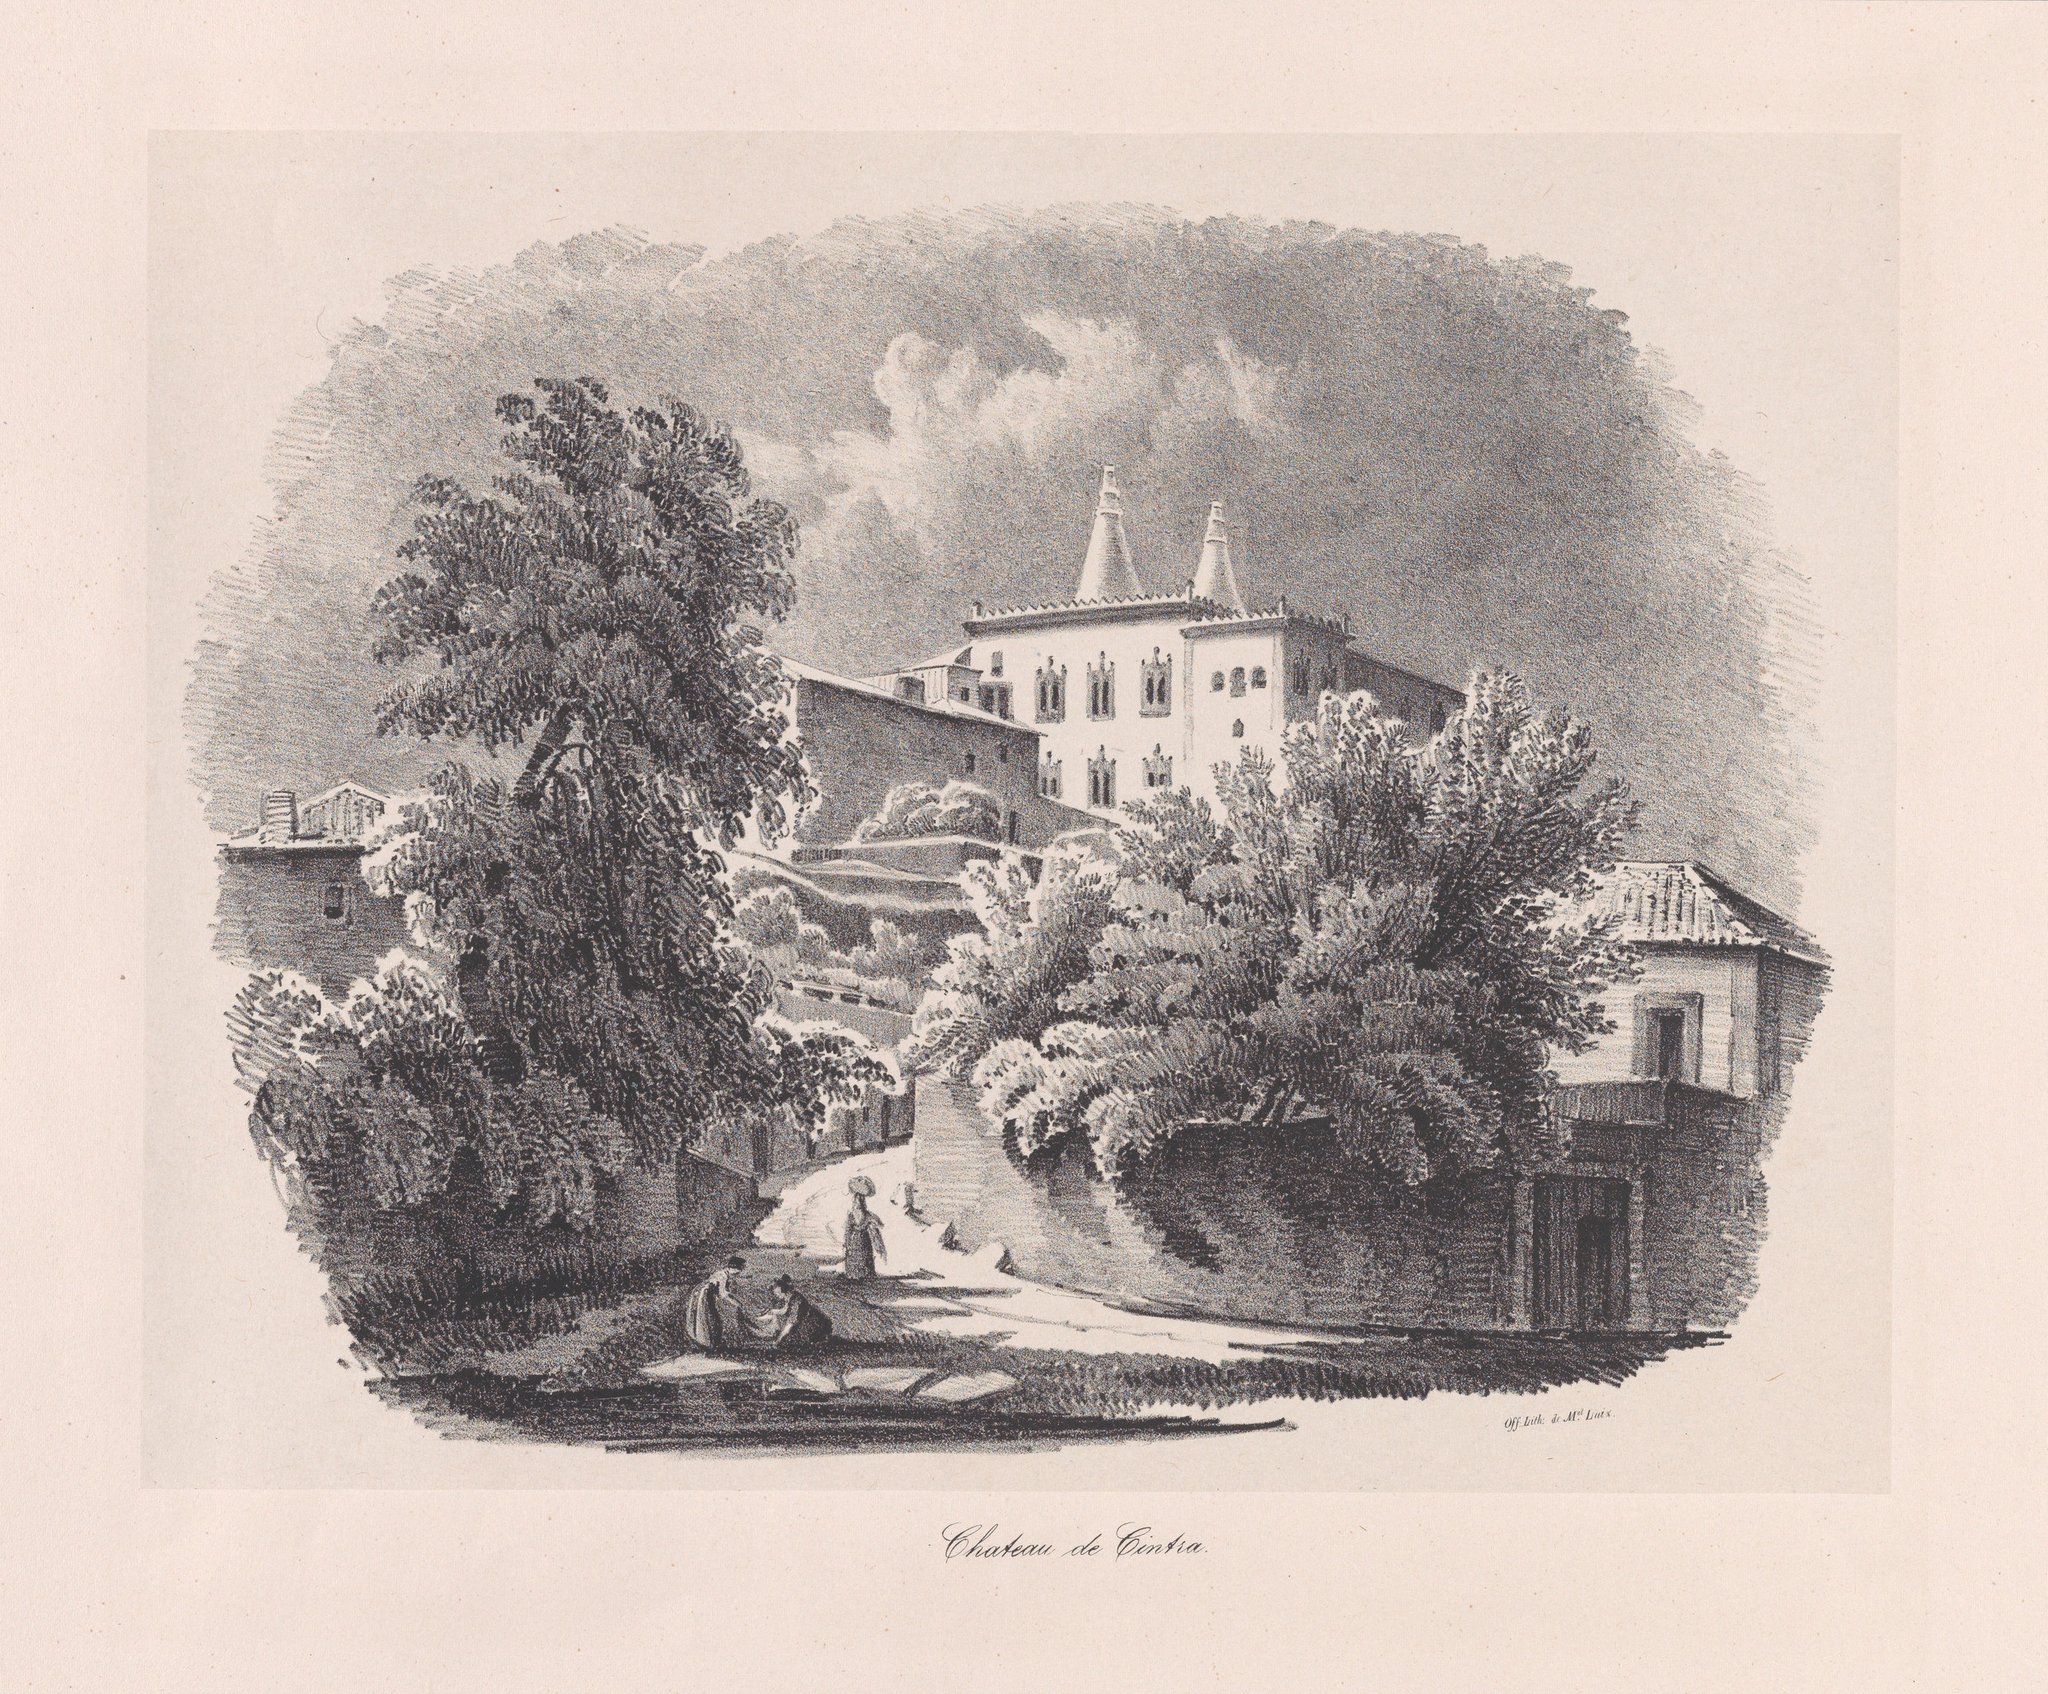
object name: print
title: View of Sintra with what is now the National Palace in the background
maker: clementine de brelaz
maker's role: artist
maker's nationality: portuguese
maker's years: 1811-1892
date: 1840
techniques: printmaking, lithograph